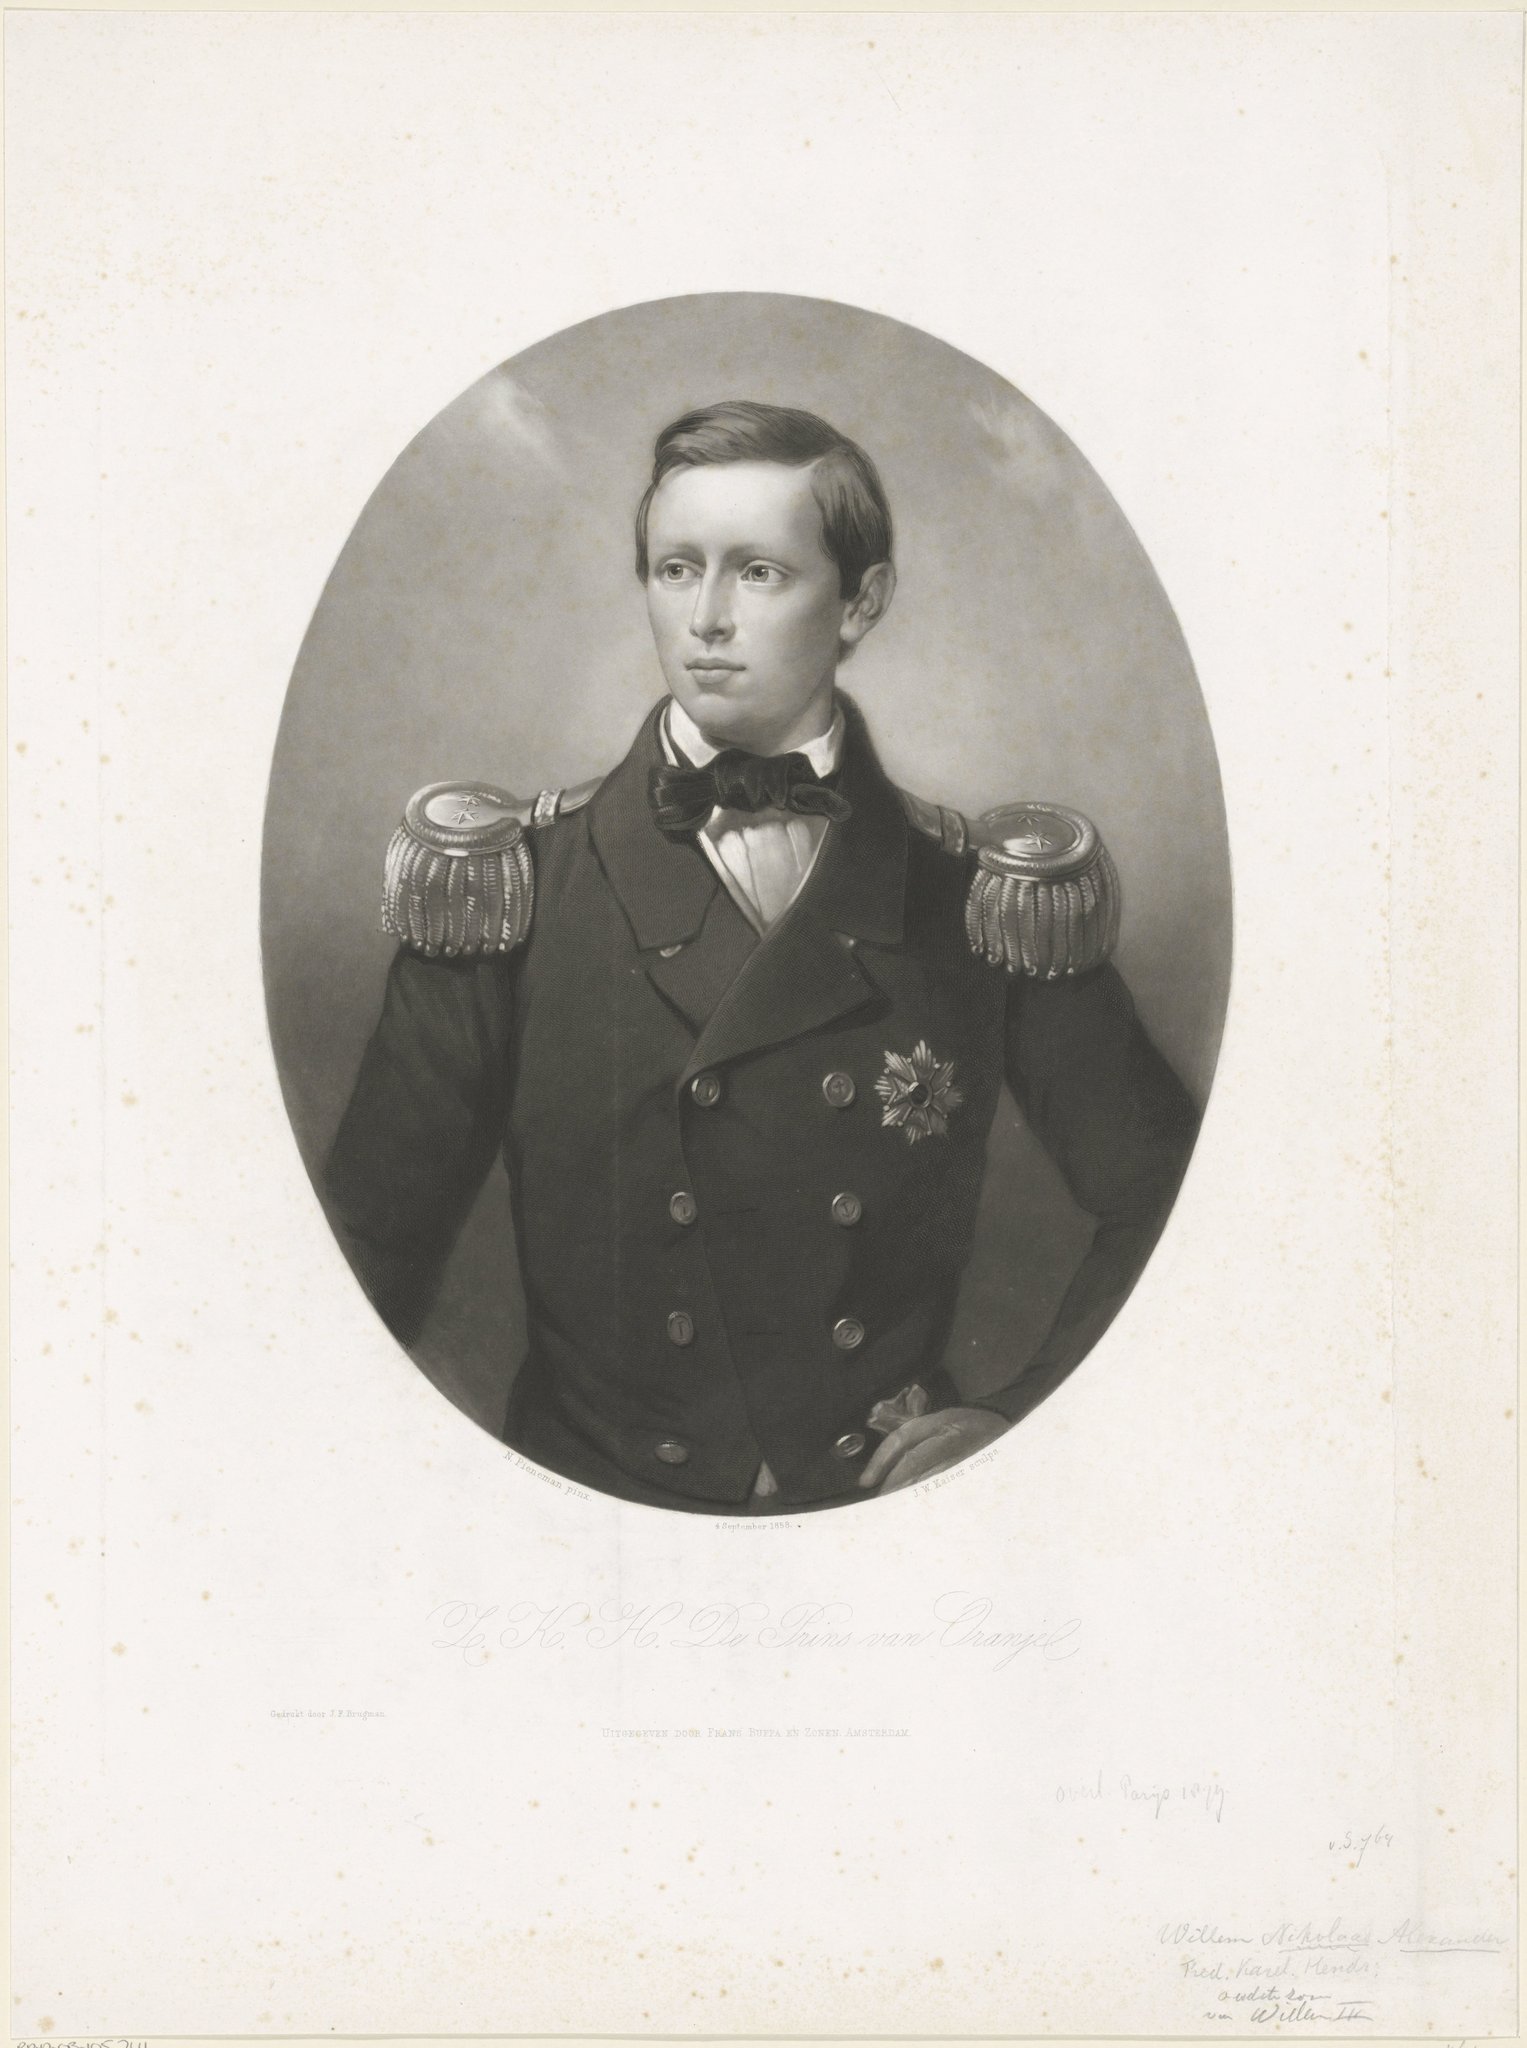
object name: print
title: Portret van Willem, prins der Nederlanden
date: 1858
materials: paper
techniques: aquatint, etching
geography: netherlands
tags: the hague, paris, willem (prins der nederlanden)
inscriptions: date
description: De hier vermelde titel verwijst naar de hoogst verkregen titel van de geportretteerde, niet per se naar de titel die de geportretteerde op deze voorstelling draagt.